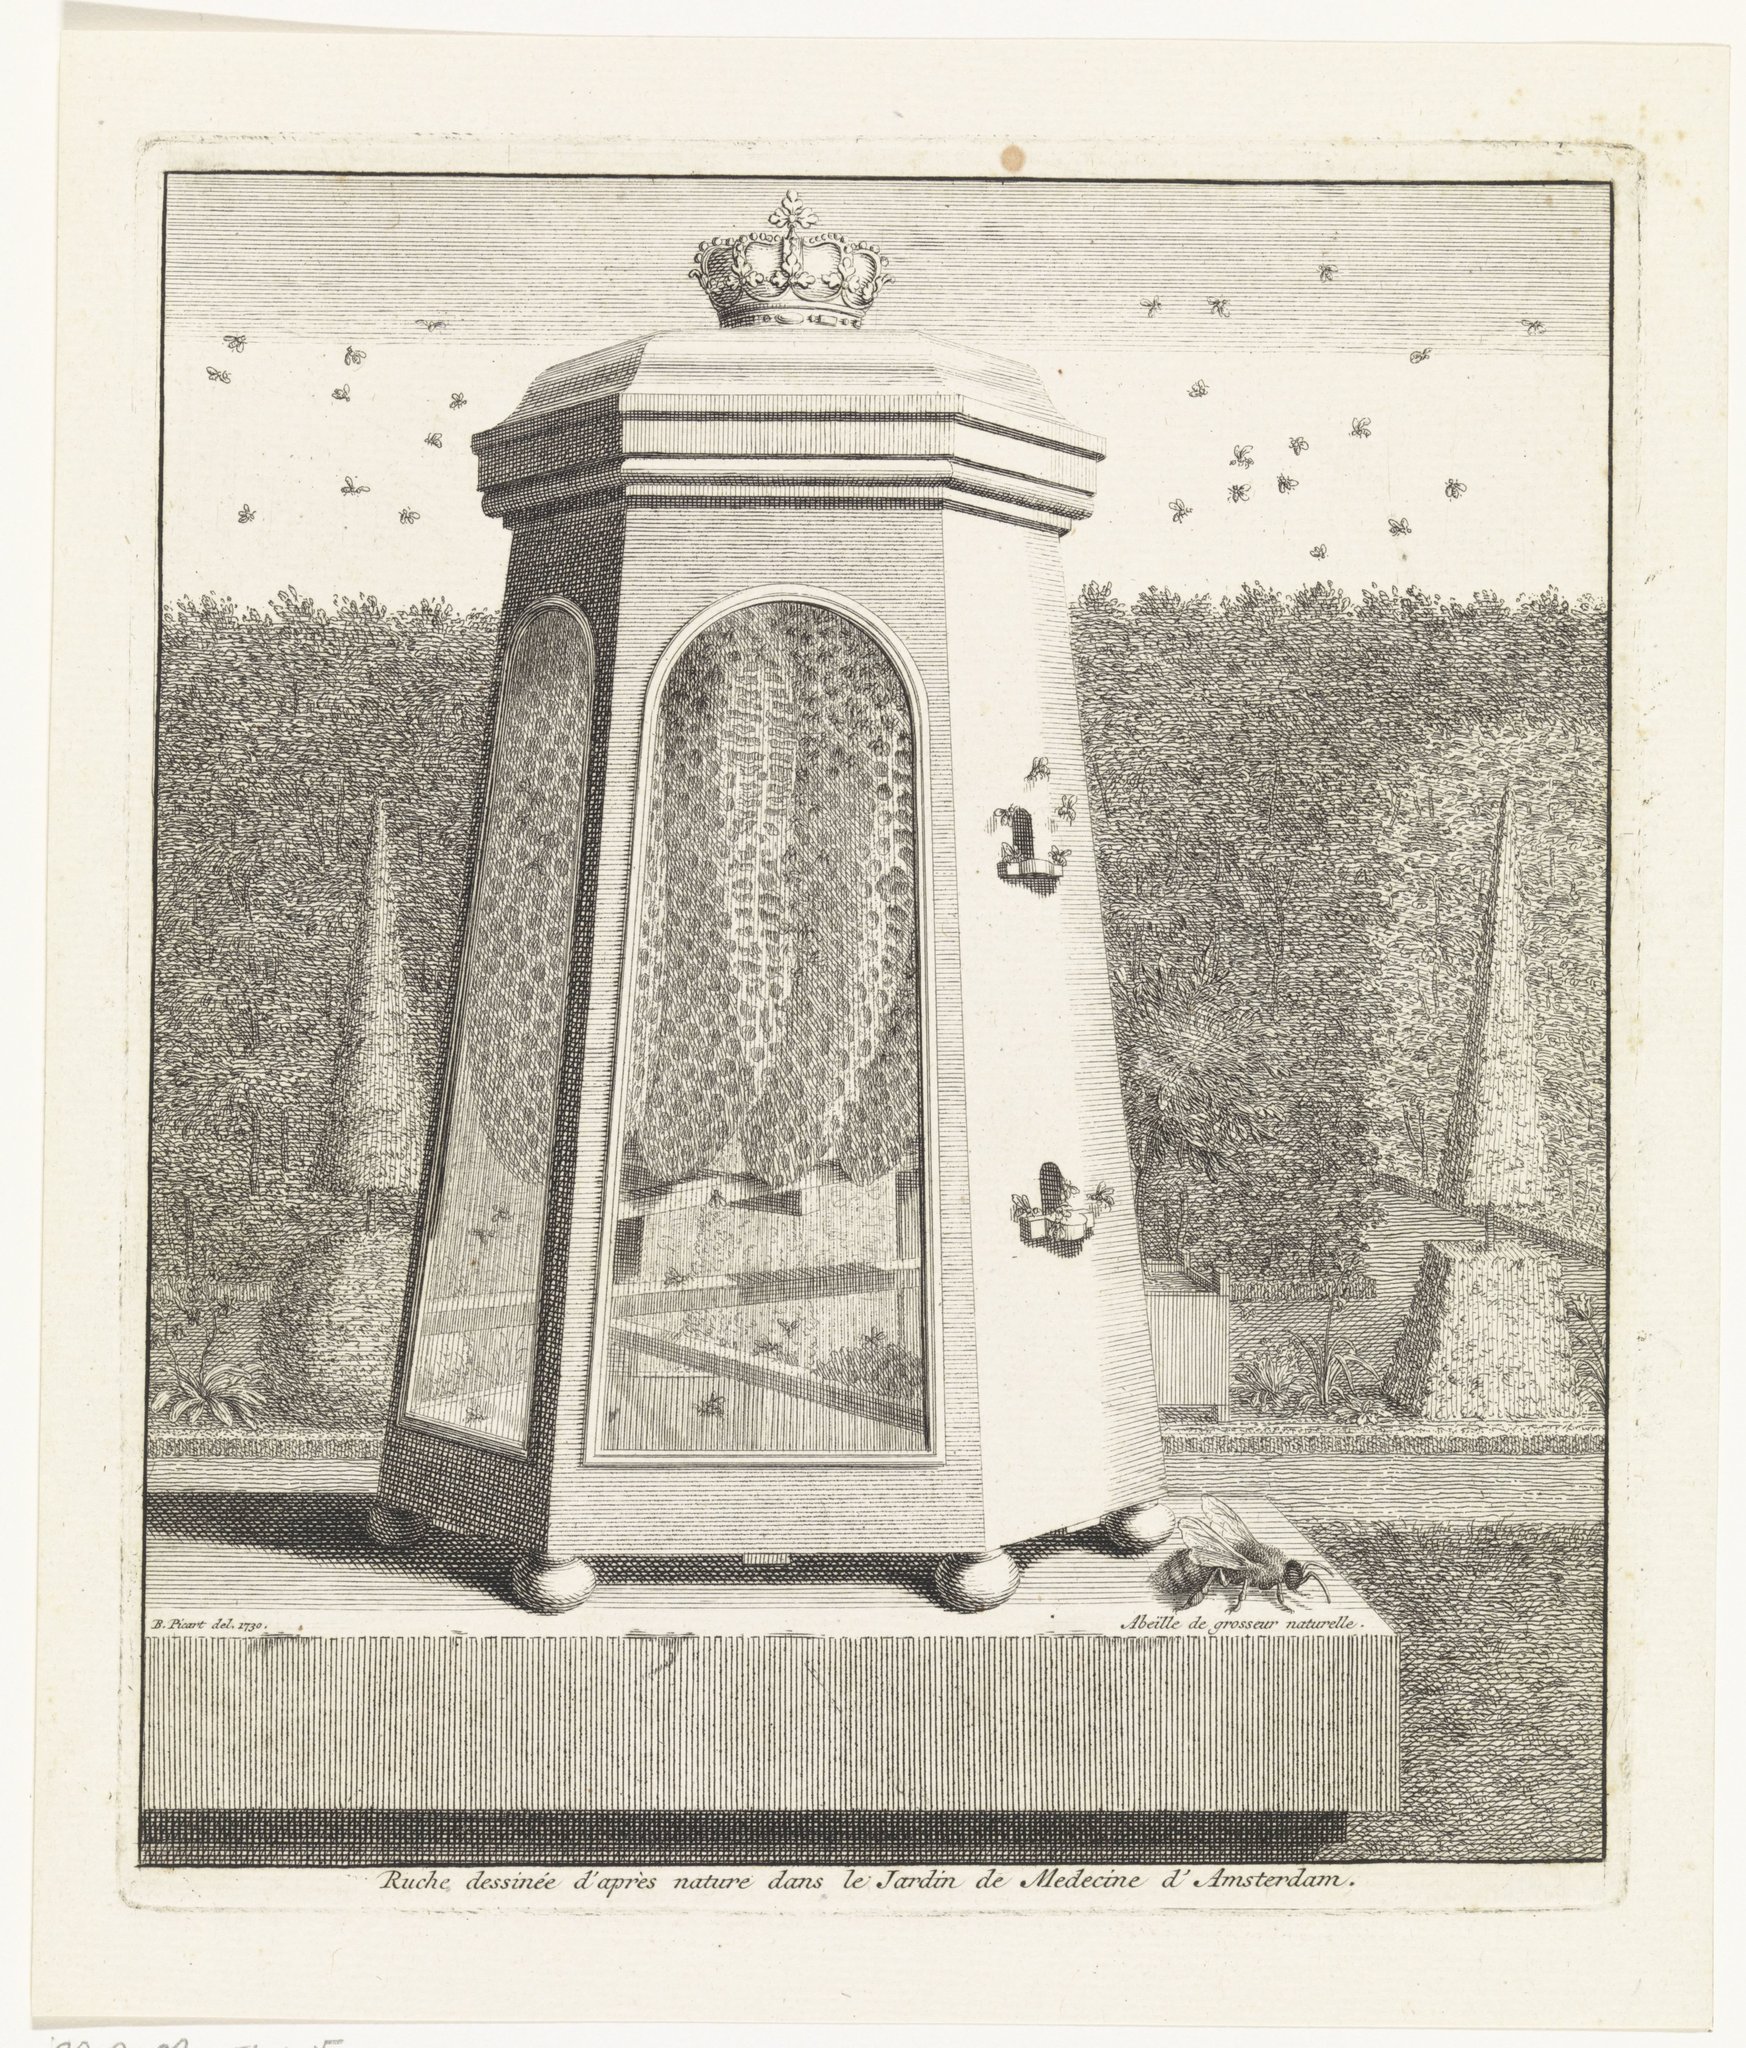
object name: print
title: Ruche, dessinée d'après nature dans le Jardin de Medecine d'Amsterdam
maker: bernard picart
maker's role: draughtsman, print maker, publisher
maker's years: 1673-1733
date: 1730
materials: paper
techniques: engraving, etching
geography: amsterdam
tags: bee-hive, insects: bee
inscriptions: collector's mark: Lugt 2228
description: Prent bedoeld voor: Chomel, Noel. Dictionnaire oeconomique, contenant divers moïens d'augmenter son bien, et de conserver sa santé. Amsterdam: Johannes Covens en Cornelis Mortier, 1732.